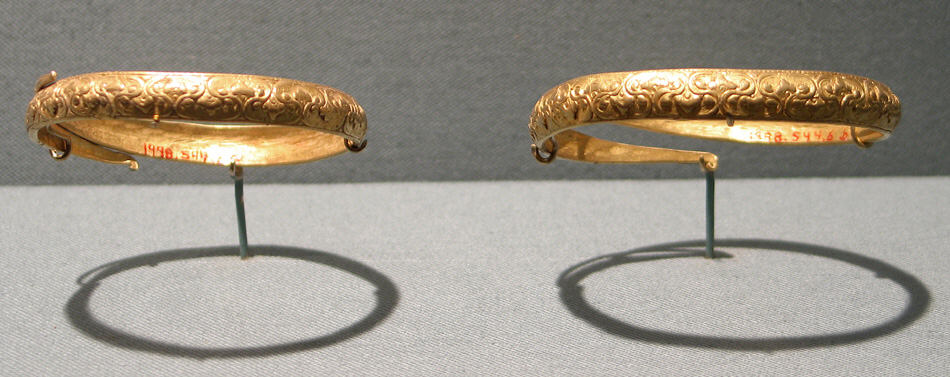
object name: bracelet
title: Pair of Small Bracelets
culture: indonesian, javanese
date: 701-933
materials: gold